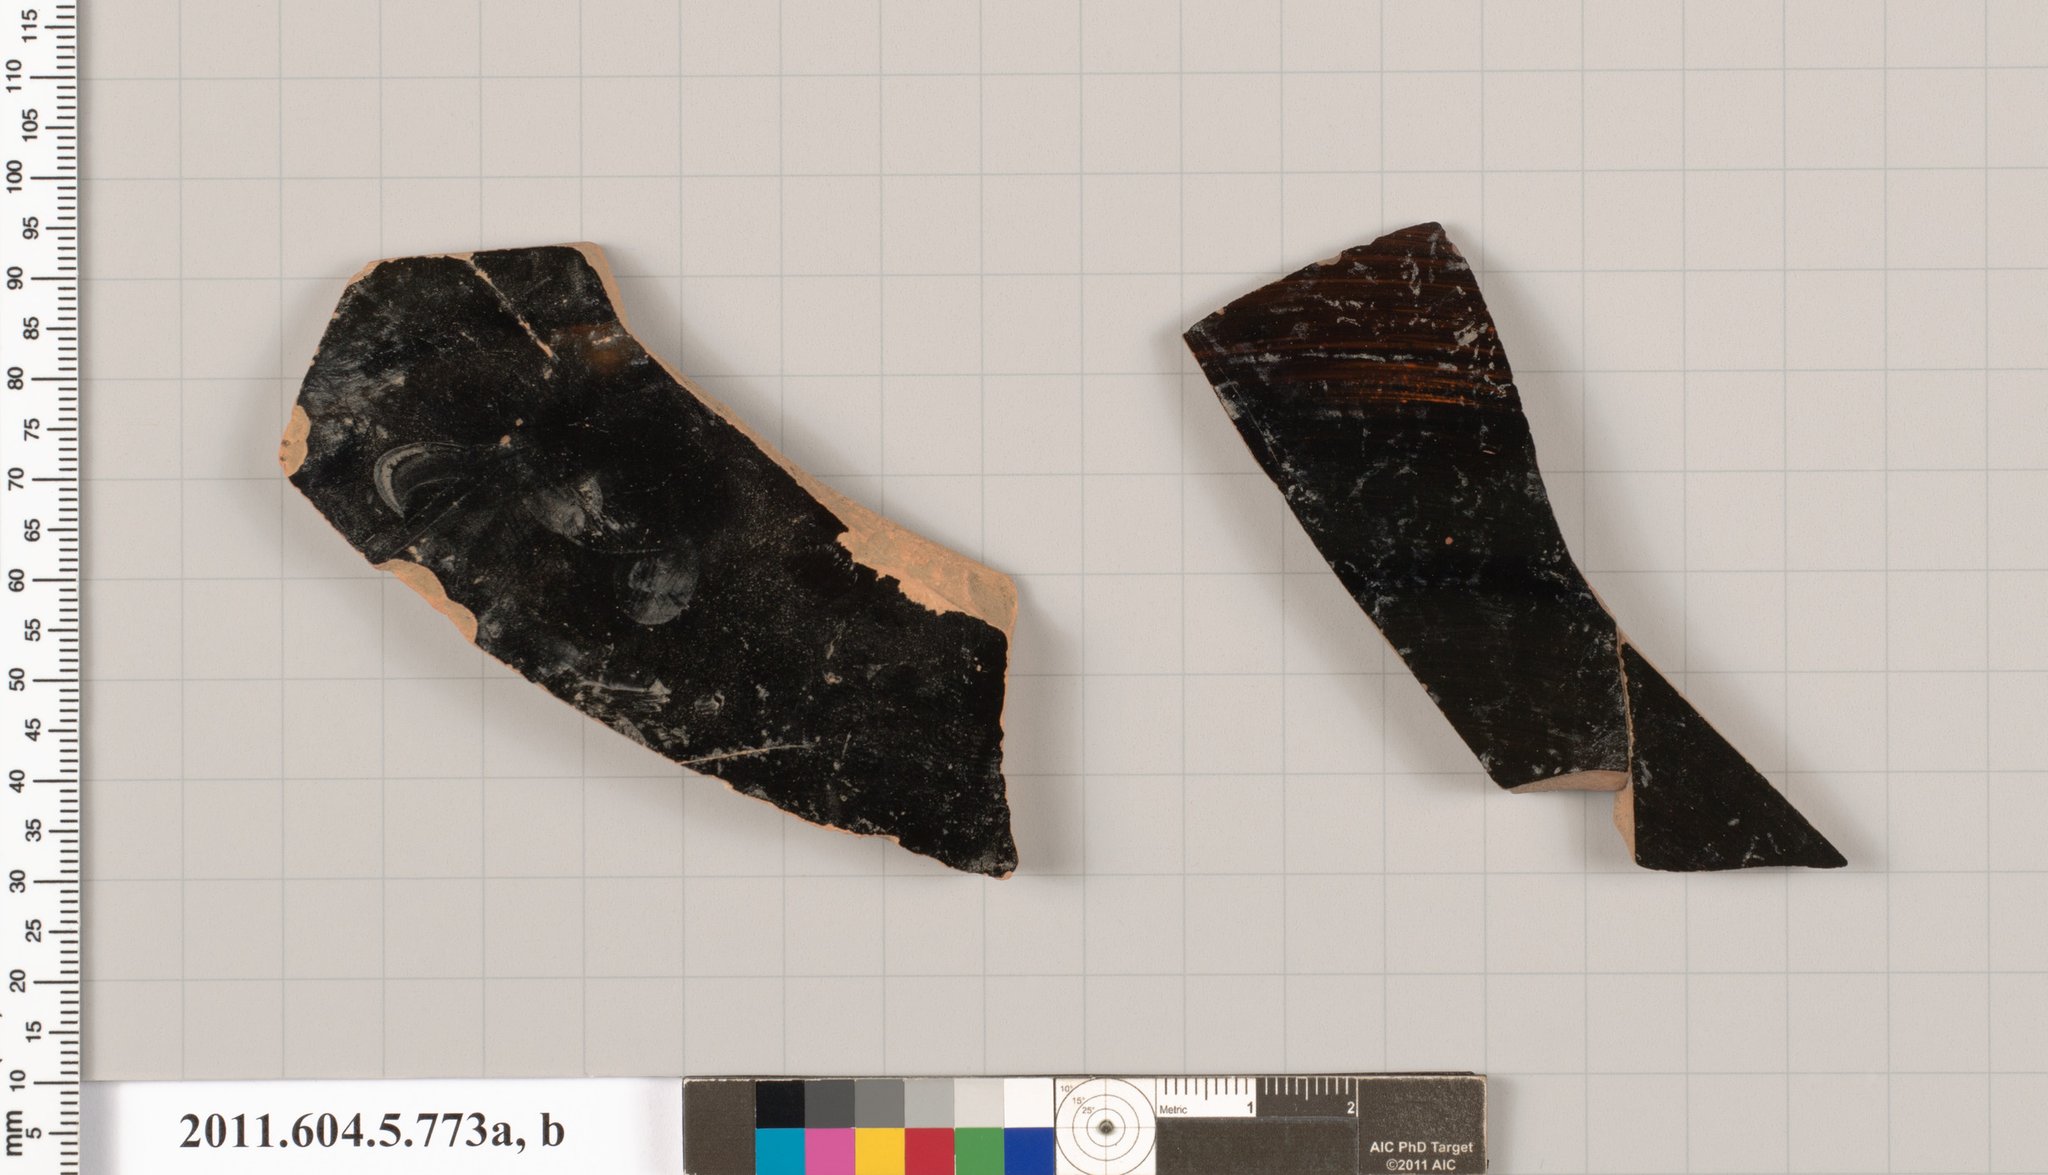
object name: kylix fragment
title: Terracotta fragments of kylikes (drinking cups)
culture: greek, attic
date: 600-401 BCE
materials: terracotta